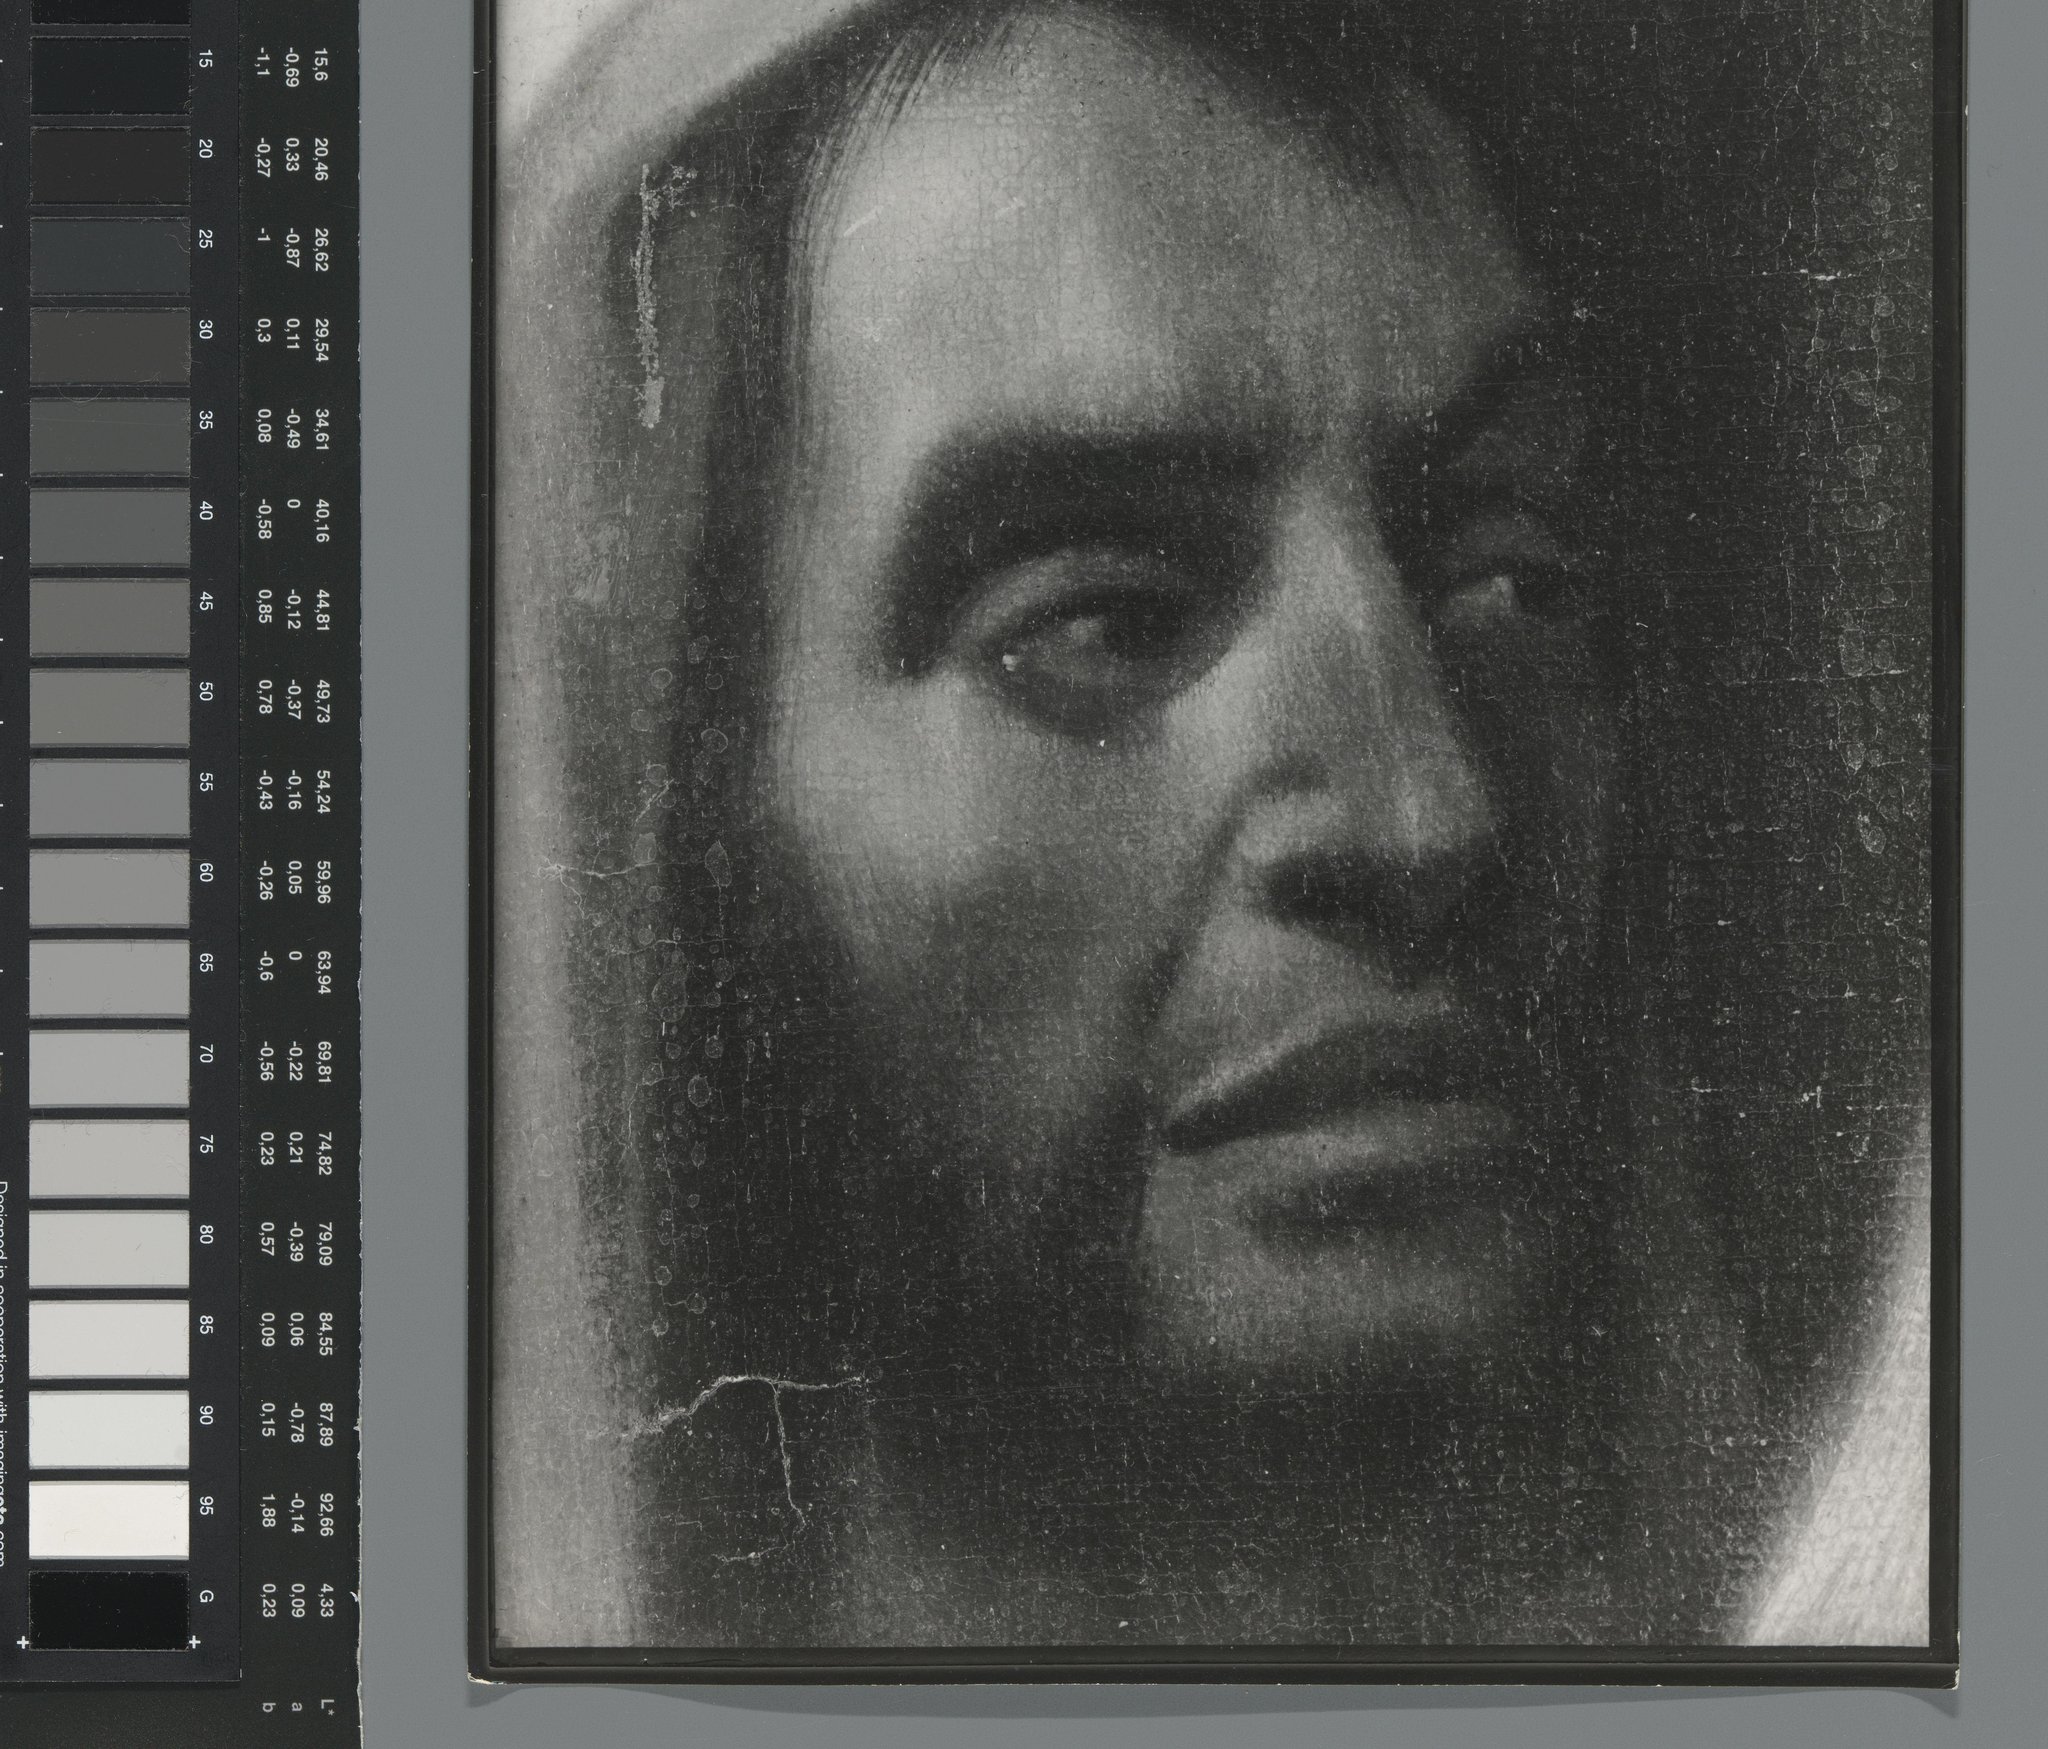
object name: photograph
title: Fotografische reproductie van een (detail) schilderij van Han van Meegeren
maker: nico zomer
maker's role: fotograaf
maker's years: 1910-1988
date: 1908-1948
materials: photographic support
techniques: gelatin silver print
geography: amsterdam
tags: picture, painting